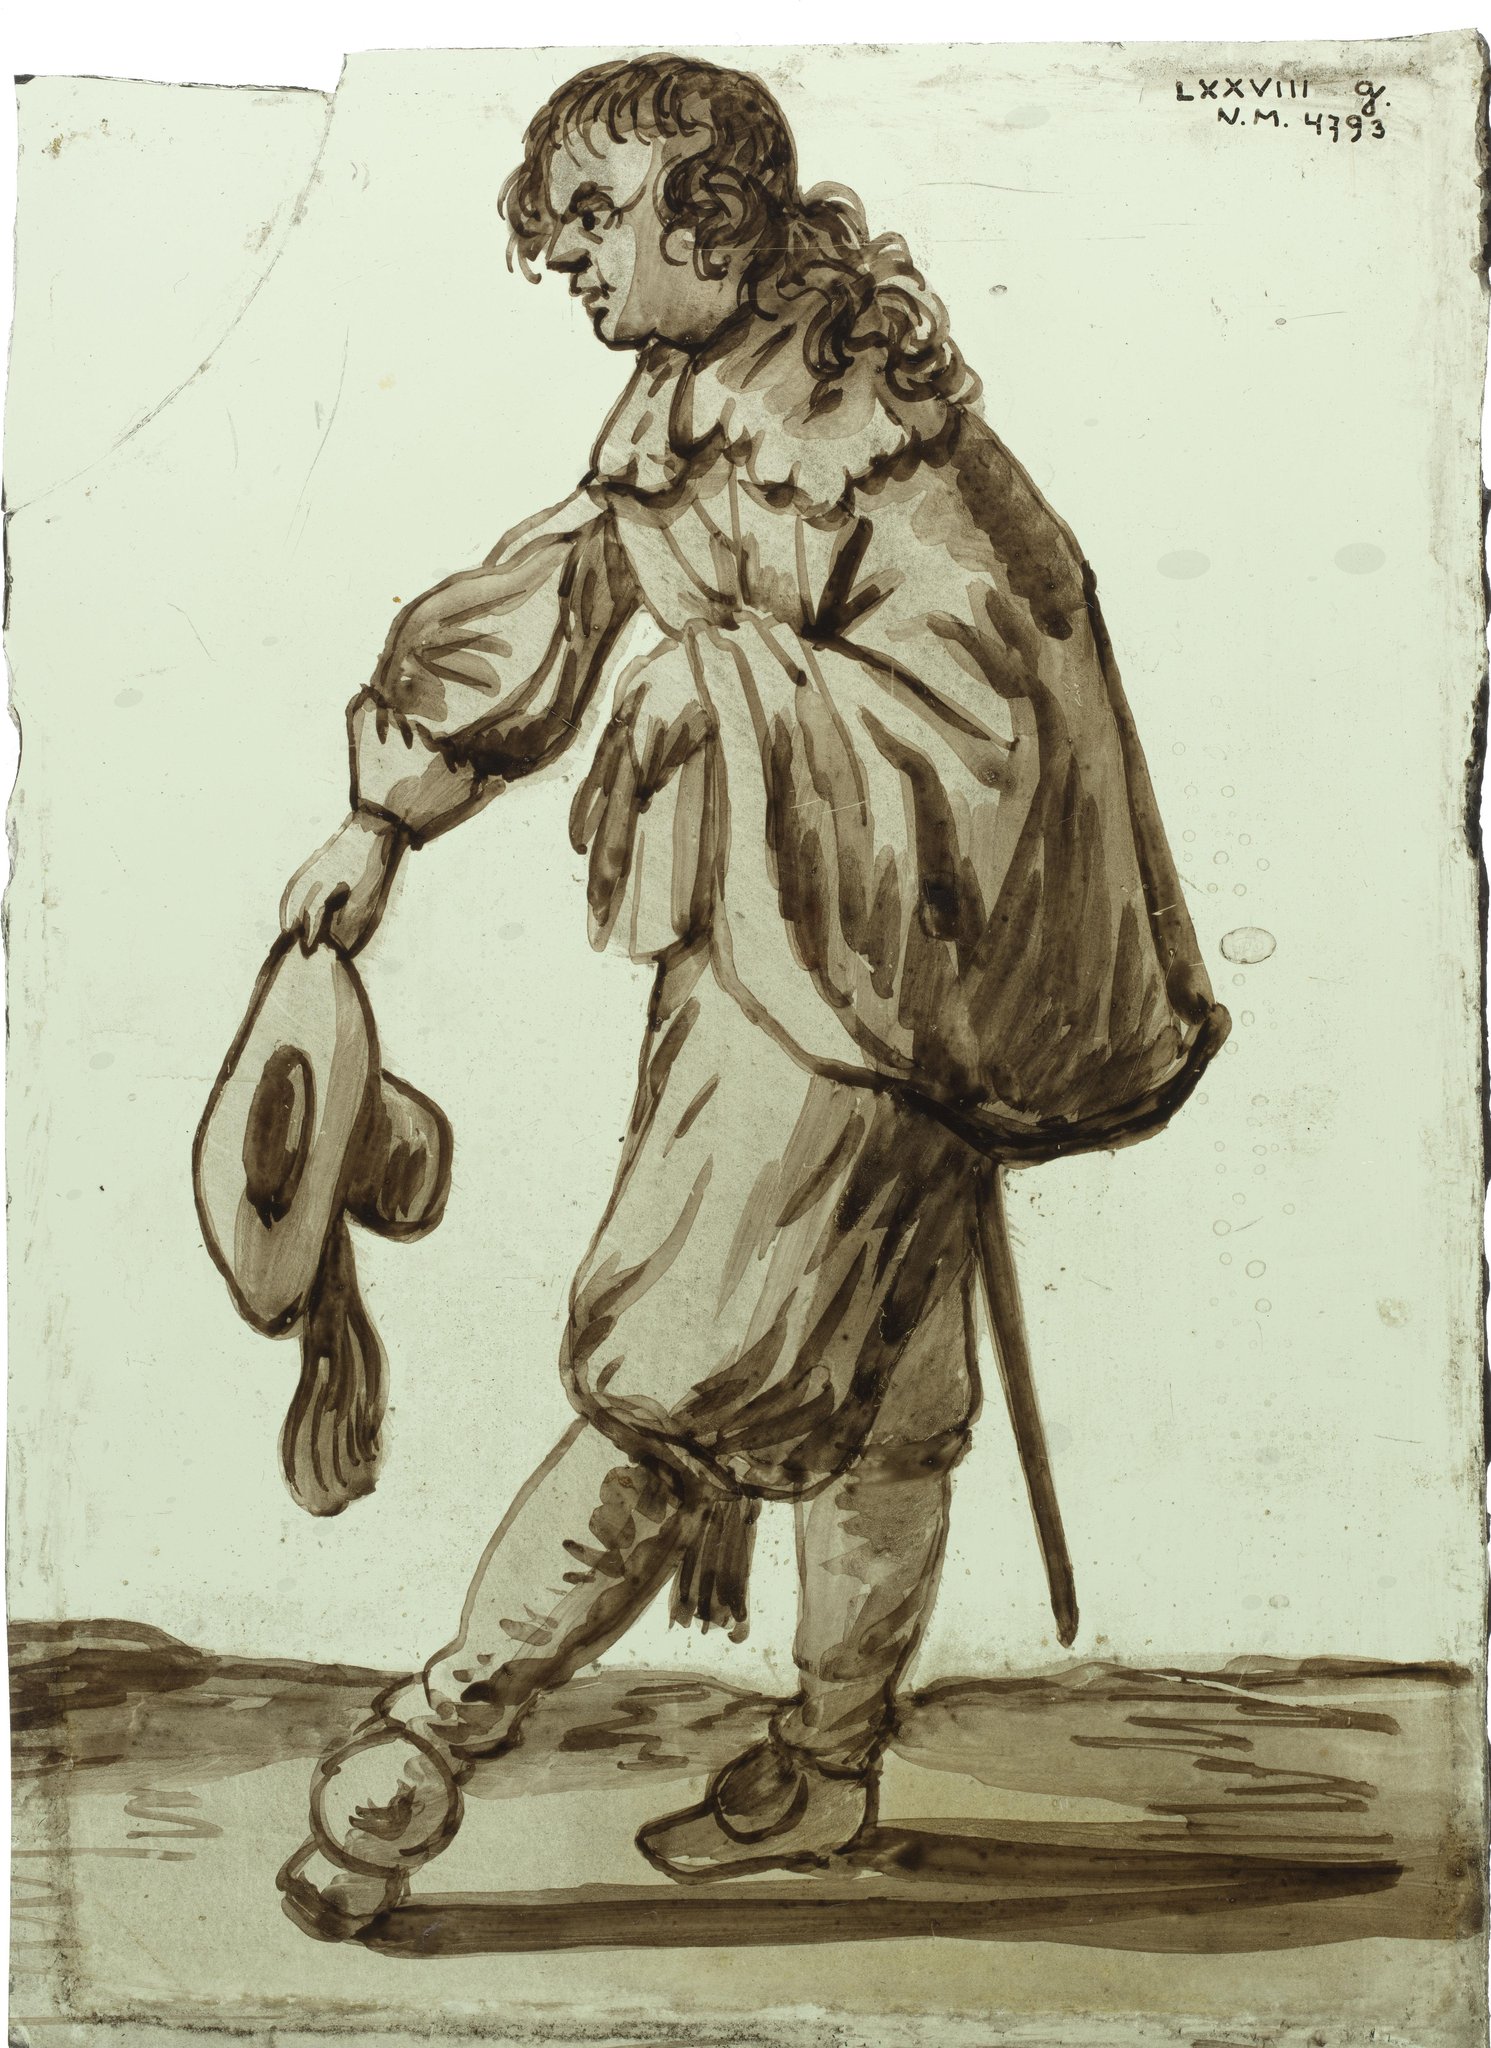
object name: light window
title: Ruit met groetende edelman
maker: Anonymous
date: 1650-1675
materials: glass, lead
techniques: enamel painting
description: Een gebrandschilderd ruit waarop afgebeeld een groetende edelman, in grisaille.